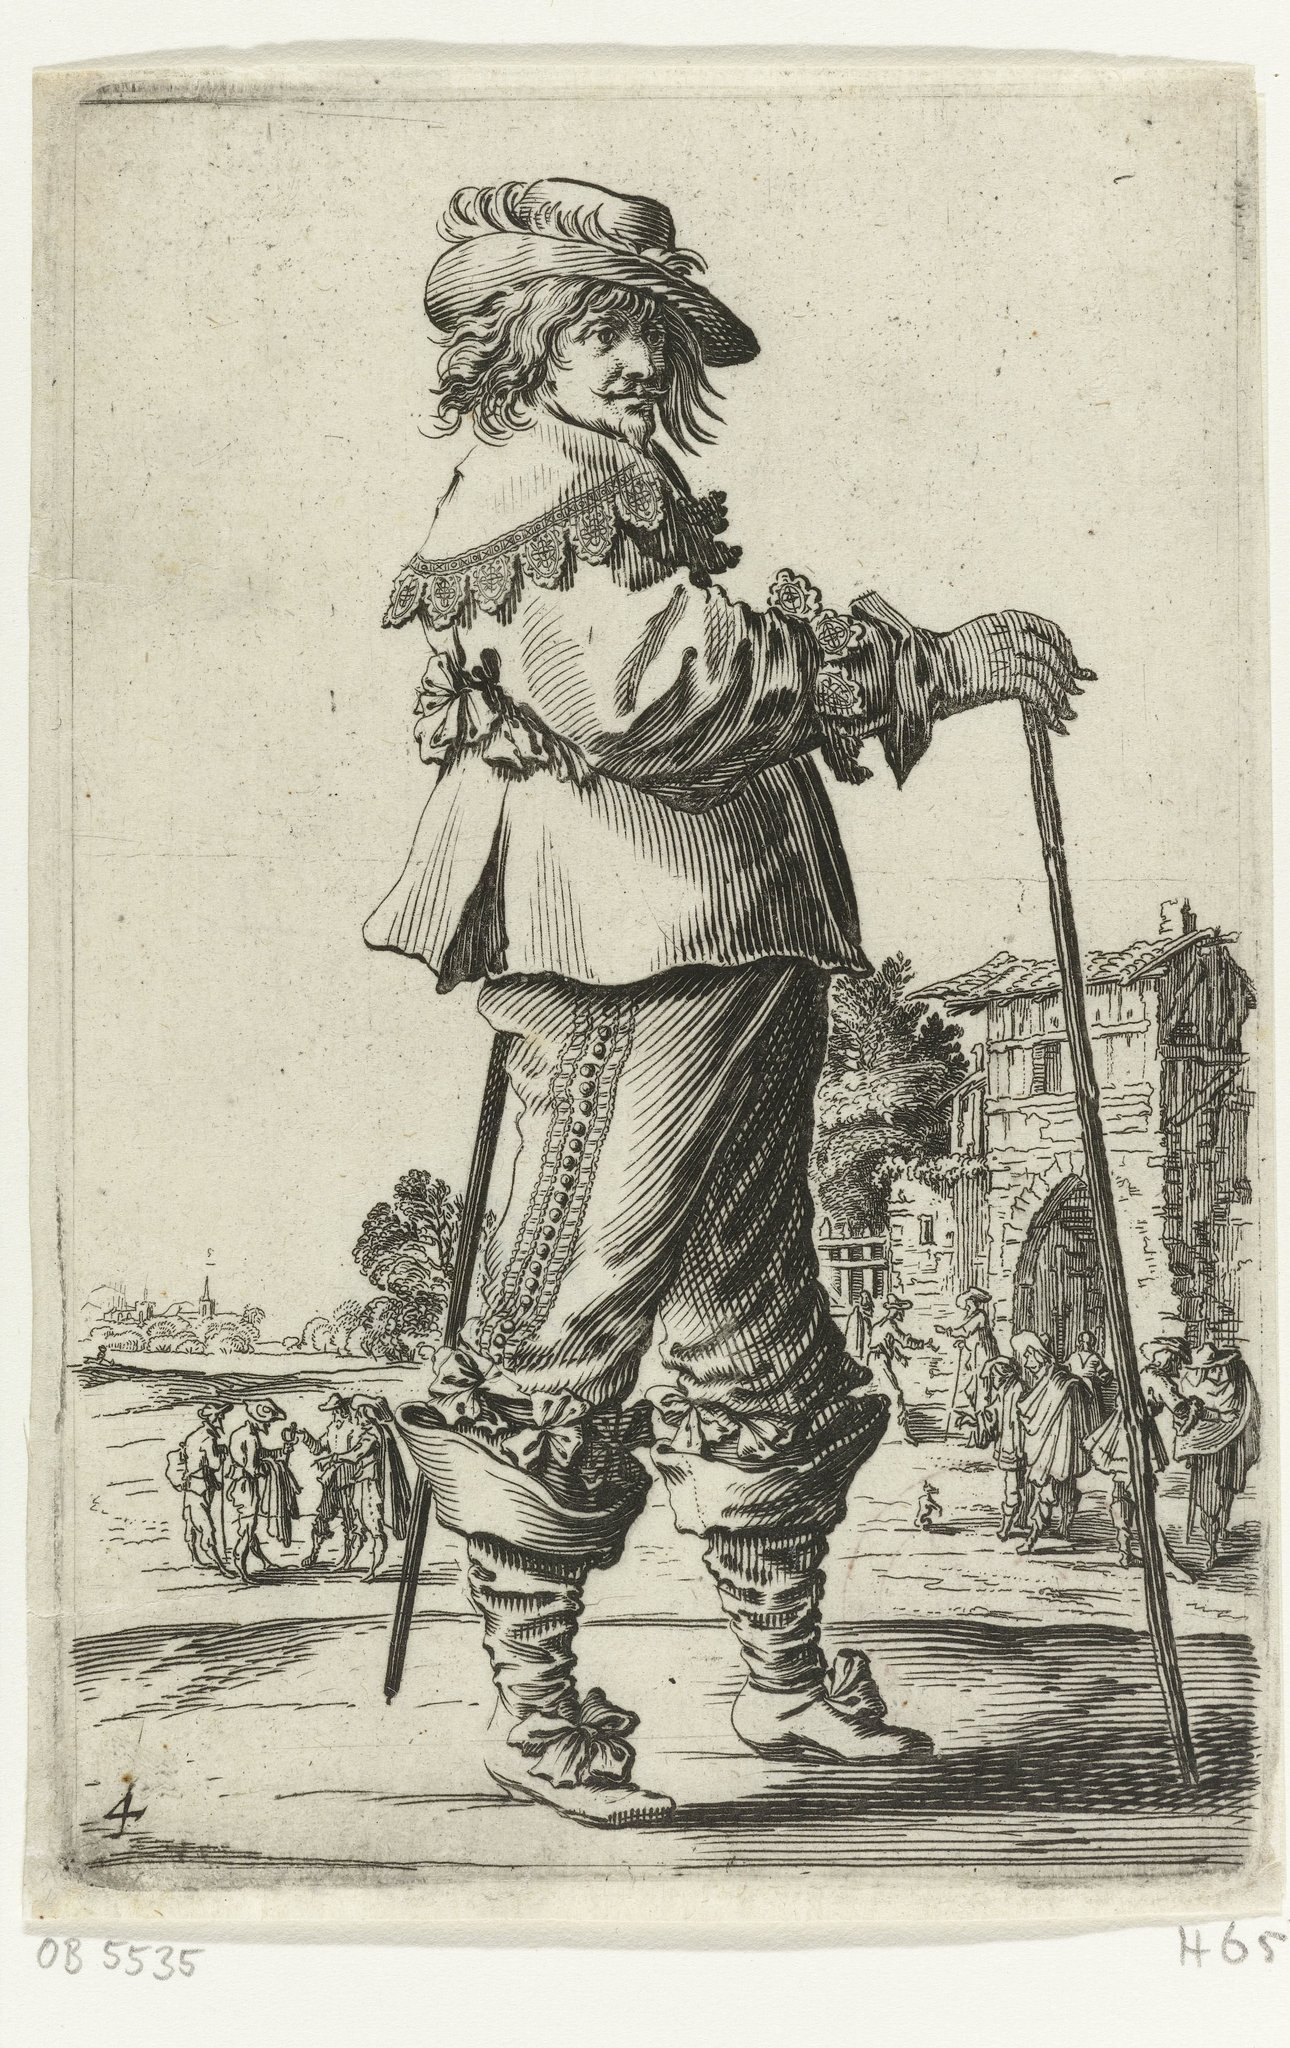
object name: costume print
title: Gewapende officieren en soldaten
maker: salomon savery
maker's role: print maker, publisher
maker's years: 1594-1683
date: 1630-1665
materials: paper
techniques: engraving, etching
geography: amsterdam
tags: walking-stick, staff, clothes, costume (+ men's clothes), officer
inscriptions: collector's mark: Lugt 240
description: Officier met wandelstok, van opzij gezien. Op de achtergrond mensen voor een bouwvallige poort. De prent maakt deel uit van een tiendelige serie met voorstellingen van gewapende officieren en soldaten, gekleed volgens de Nederlandse mode ca. 1625-1635.